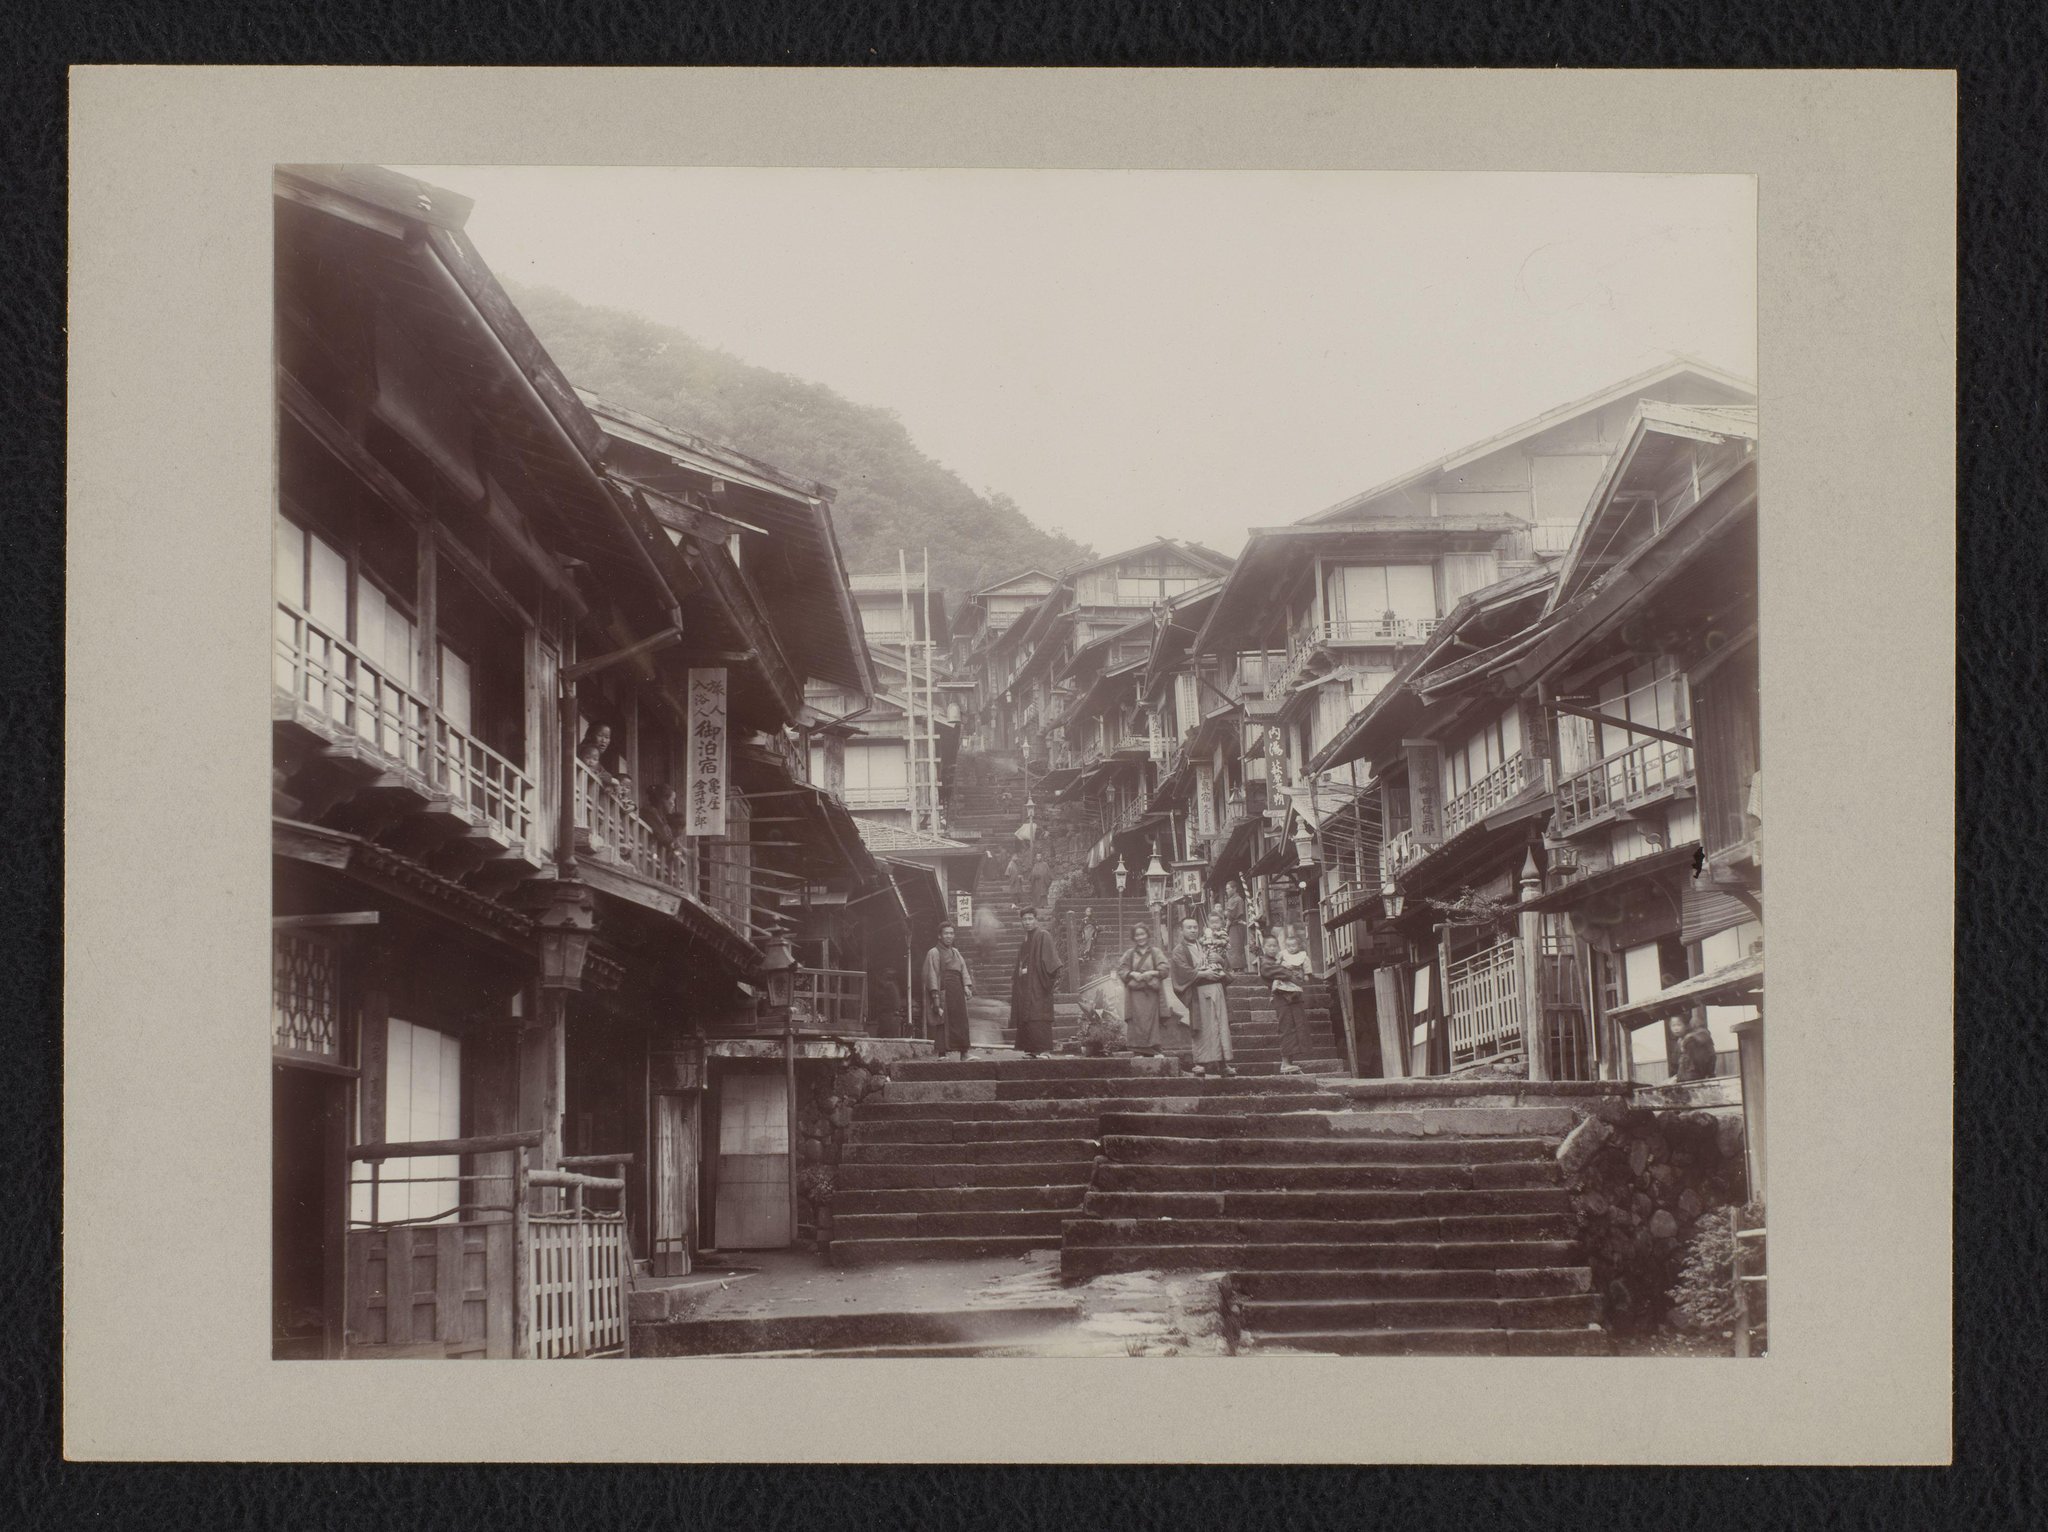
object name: photograph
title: Straat in Ikaho met traptreden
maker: Anonymous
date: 1895-1915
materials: cardboard, photographic support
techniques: collodion silver print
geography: ikaho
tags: ikaho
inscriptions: annotation: ‘42. Ikao.’